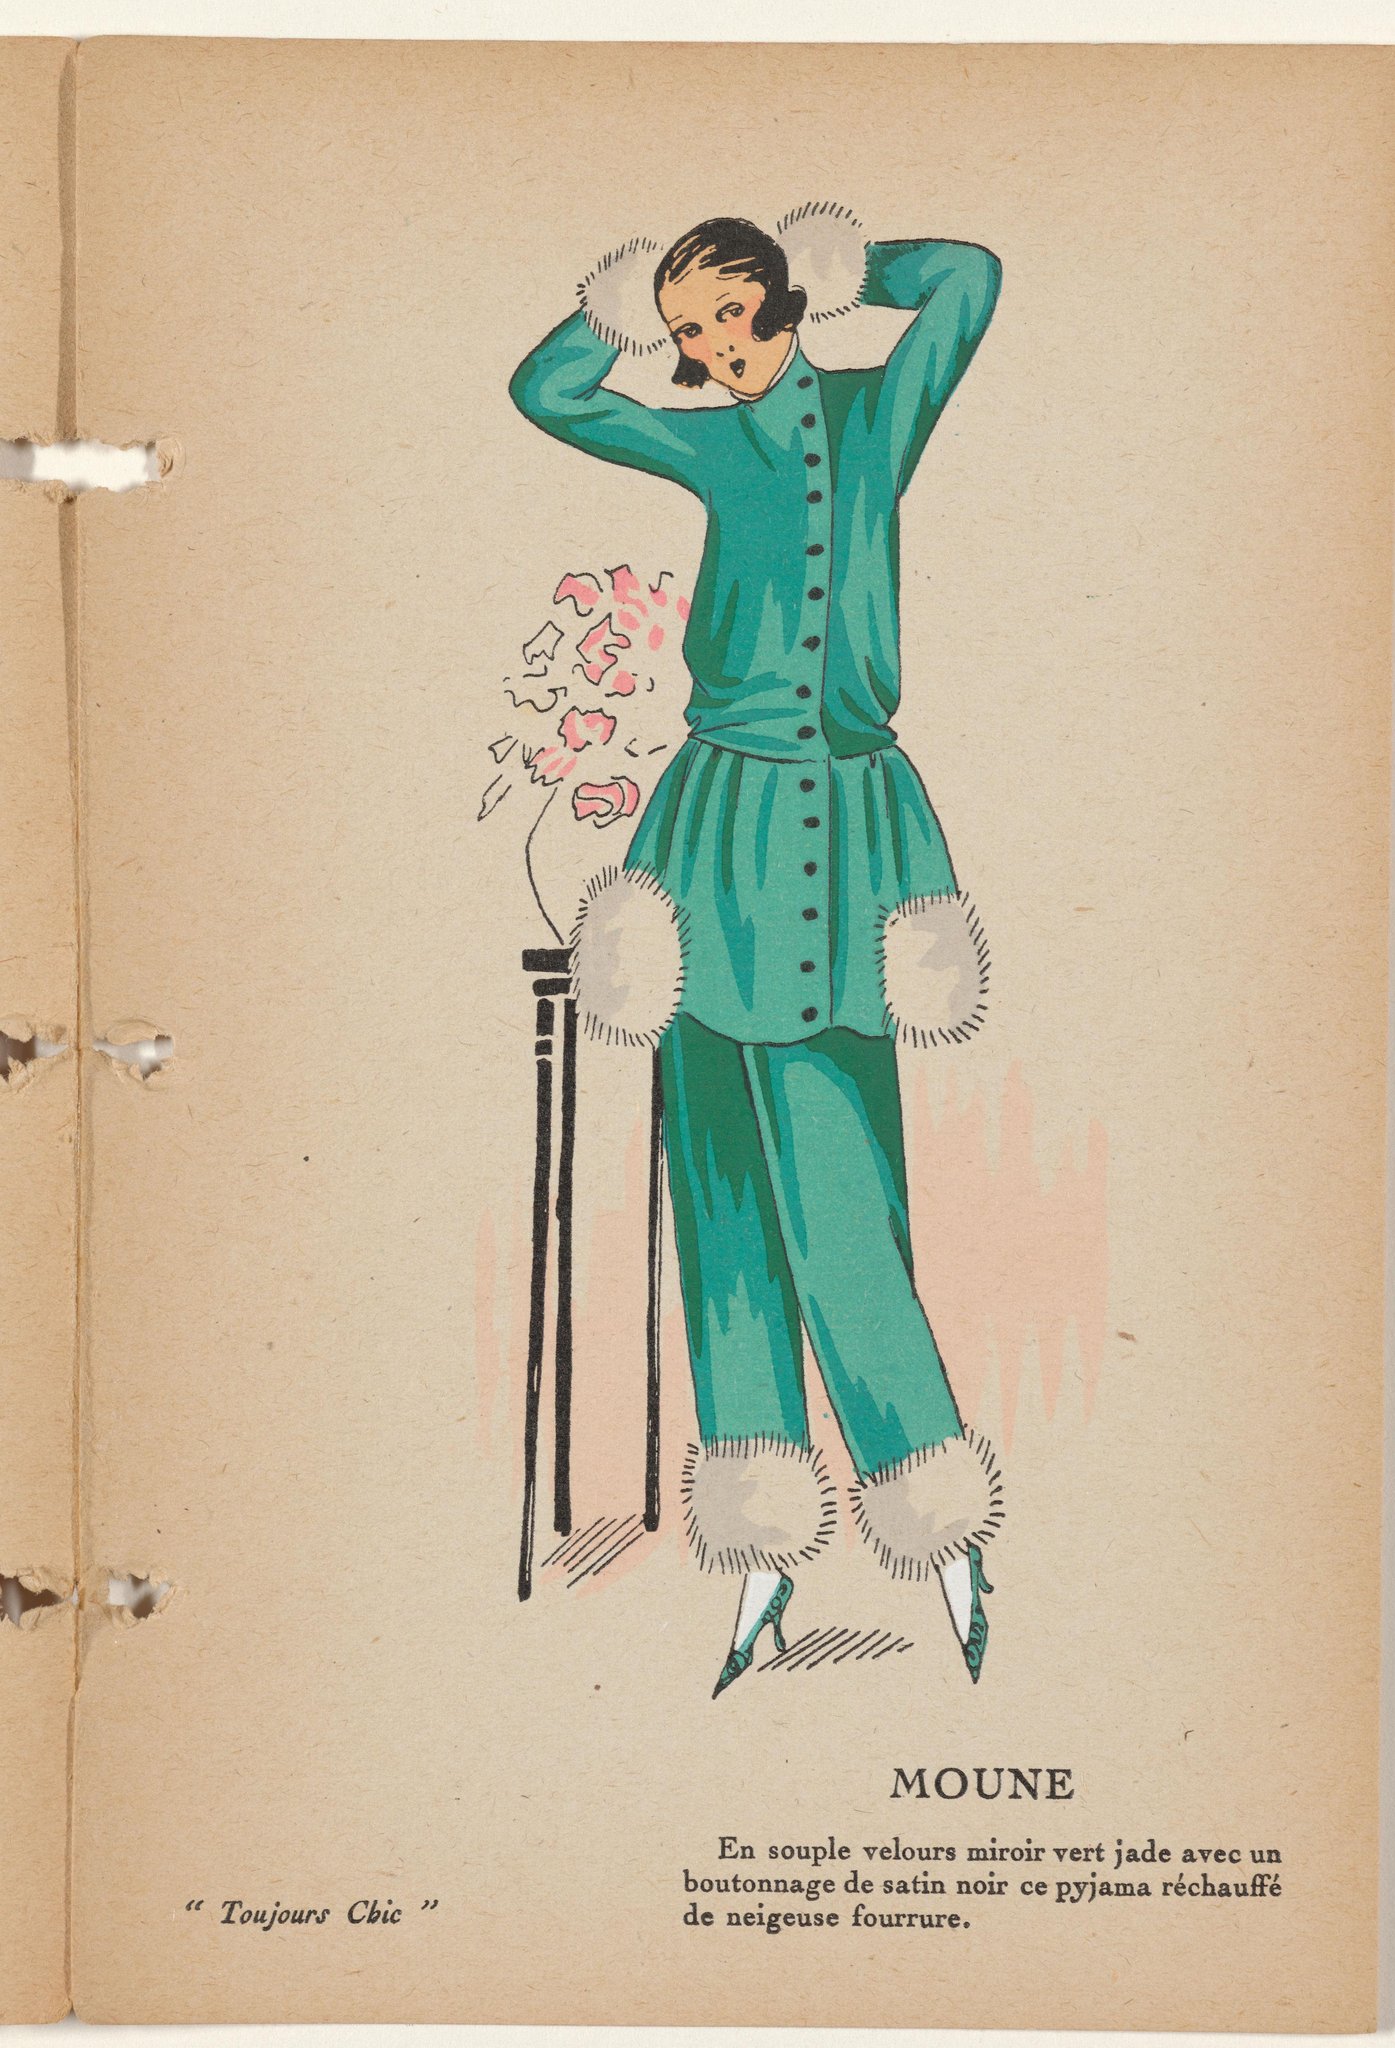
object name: fashion print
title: Toujours Chic Les Deshabillés, Hiver 1921-1922: Moune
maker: g-p. joumard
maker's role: publisher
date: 1921-1922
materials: paper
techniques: letterpress printing, pochoir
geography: paris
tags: fashion plates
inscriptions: date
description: Prent uit Catalogus "Toujours Chic" waarin een overzicht van de wintermode 1921-1922.